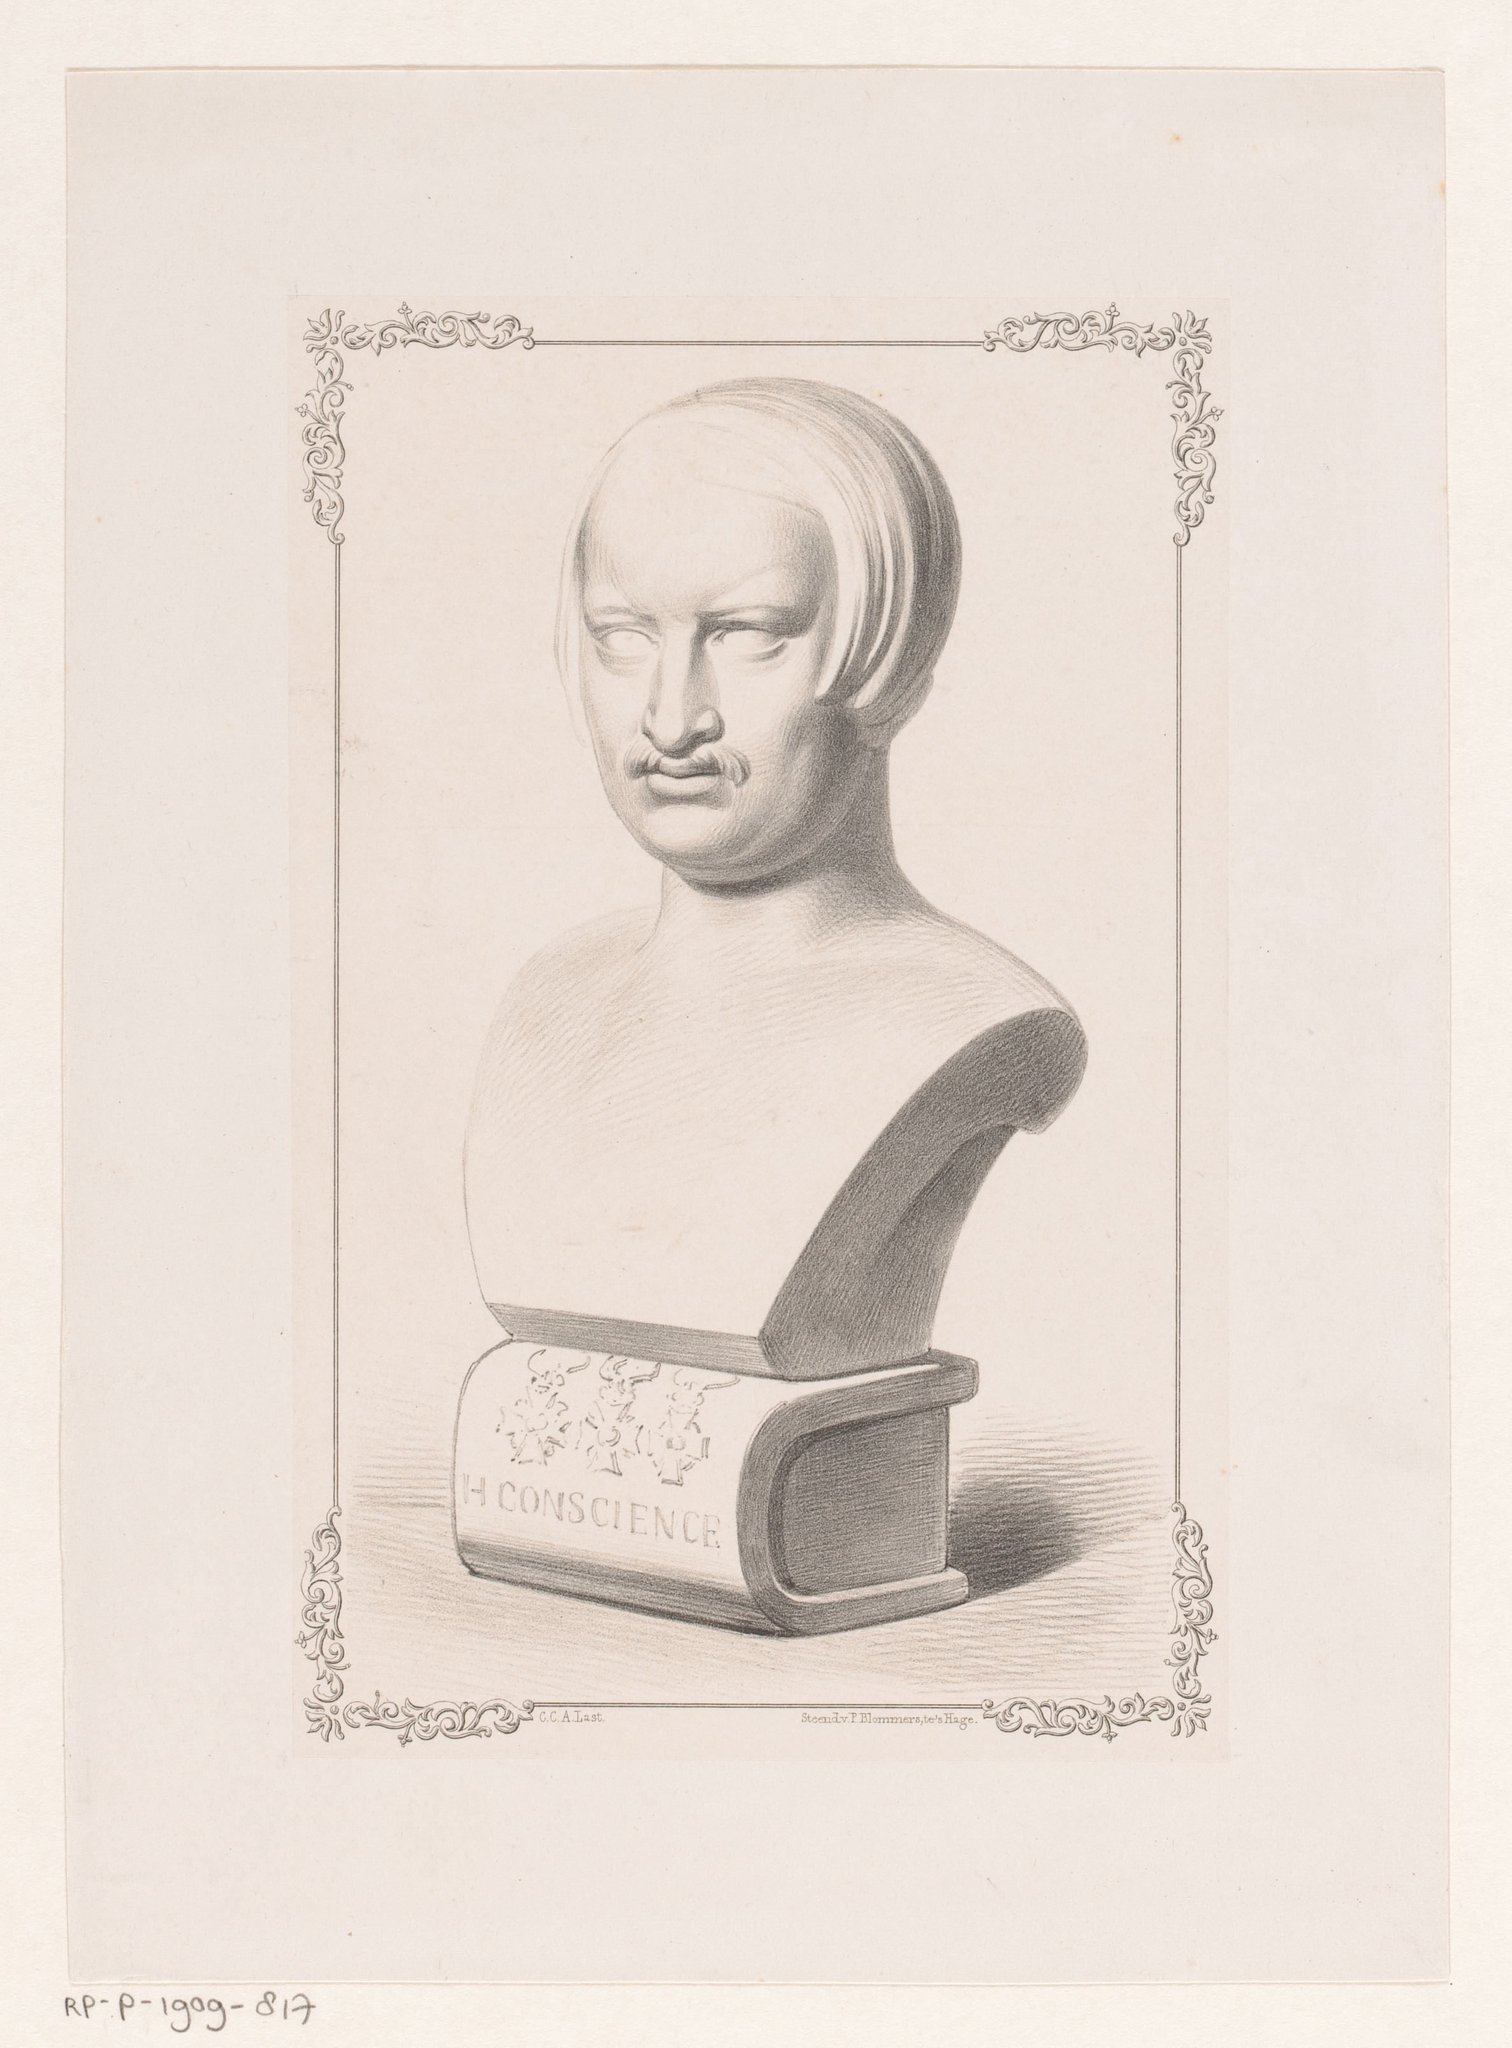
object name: print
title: Portretbuste van Hendrik Conscience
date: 1842-1887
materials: paper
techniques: lithograph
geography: netherlands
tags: antwerp, knighthood order, sculpture, historical persons (+ (full) bust portrait)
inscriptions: collector's mark: Lugt 2228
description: De sokkel waarop de buste staat bestaat uit een boek met daarop zijn naam en drie ridderorden.